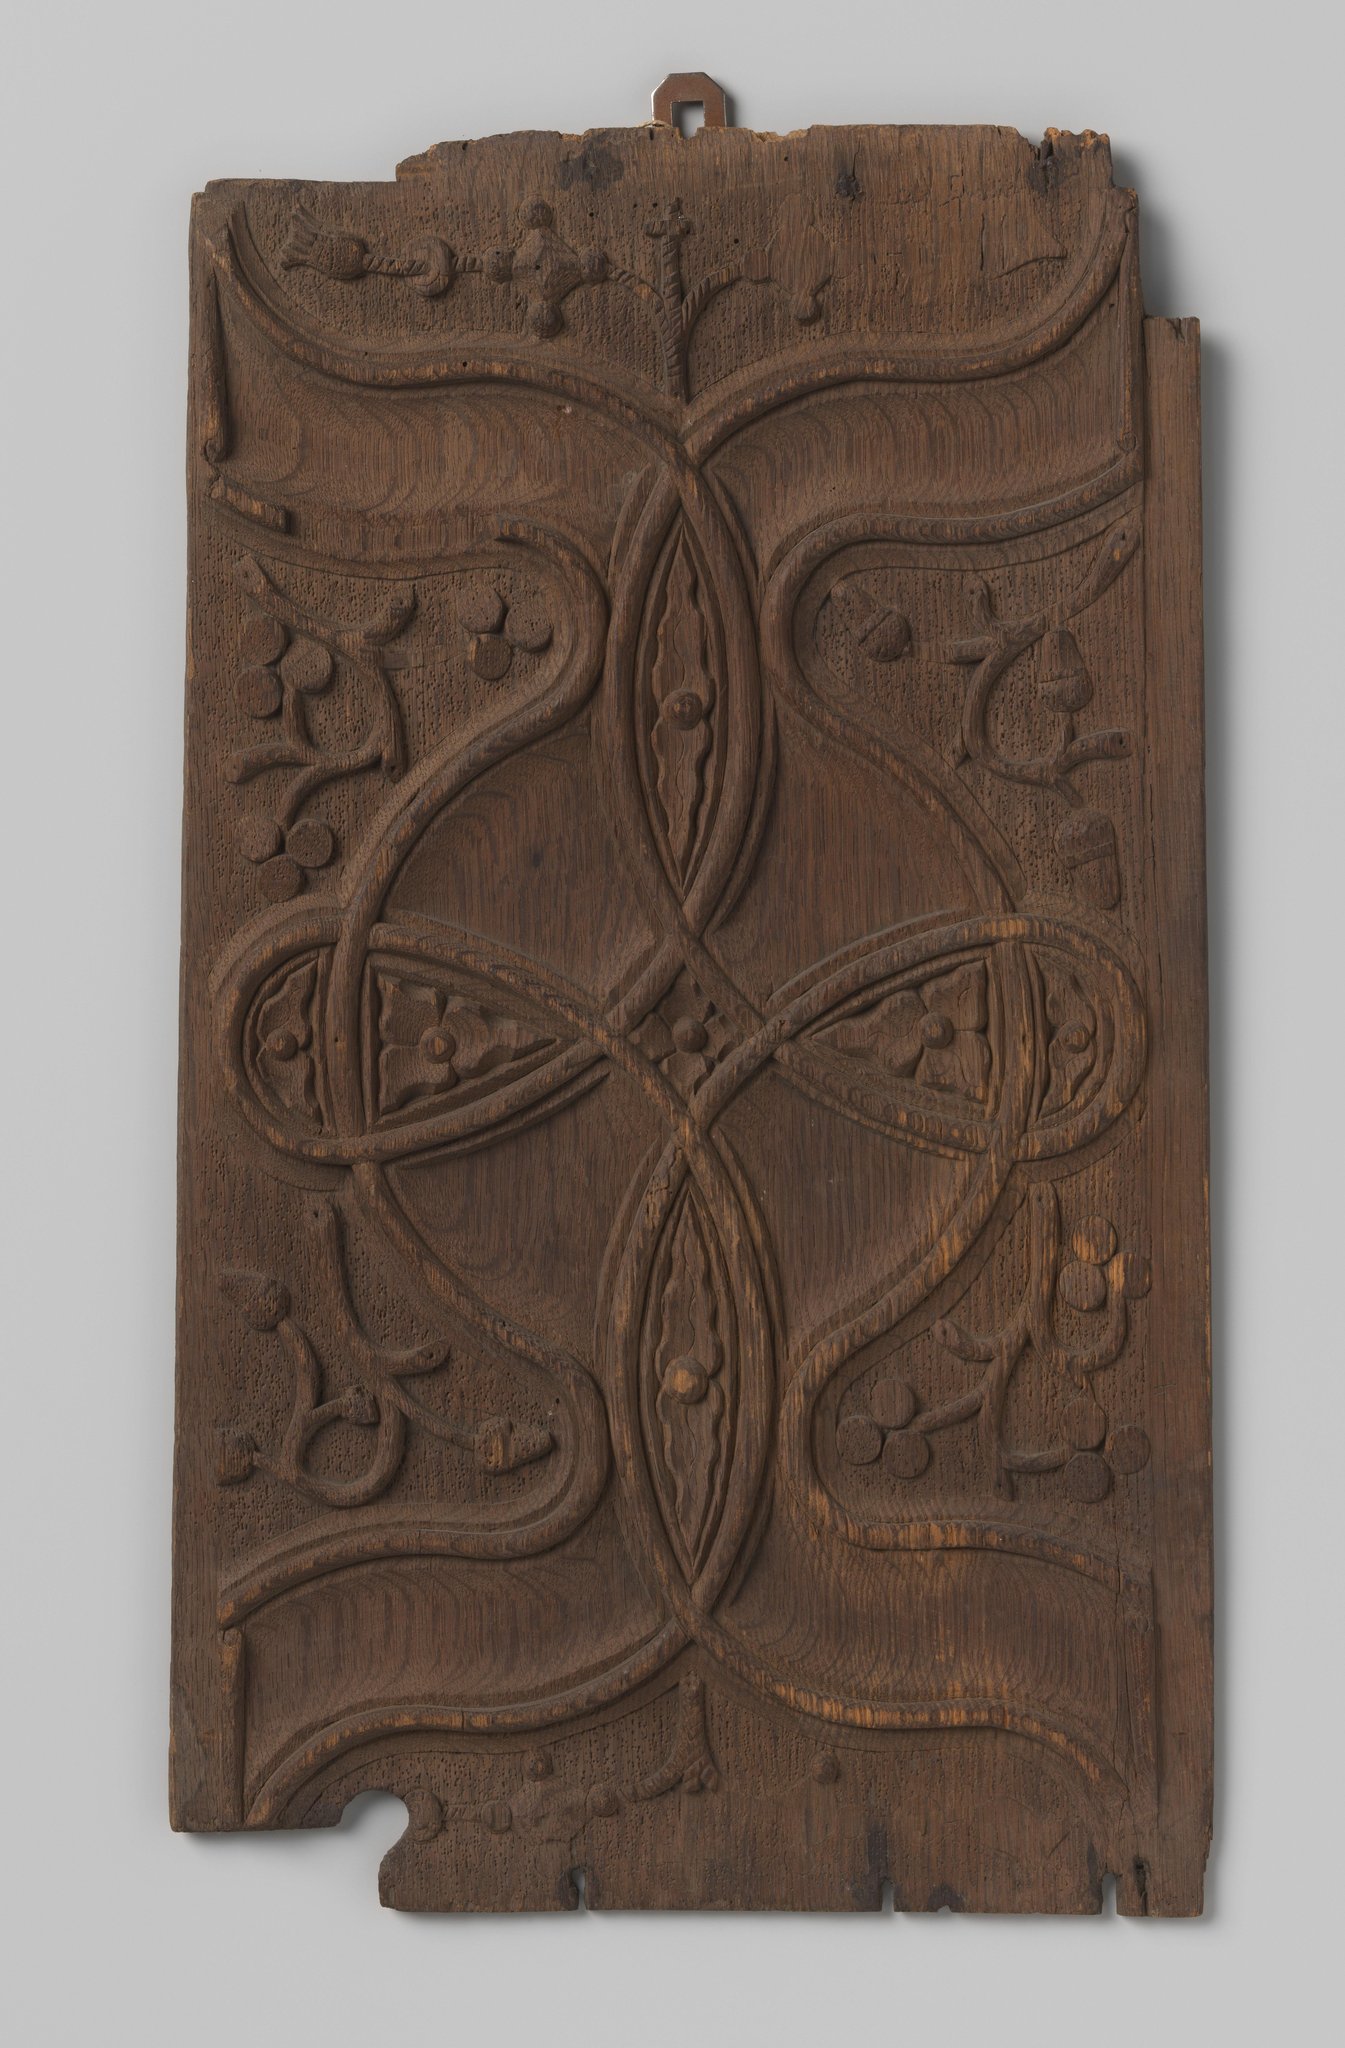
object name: betimmering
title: Interieuronderdeel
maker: Anonymous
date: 1500-1550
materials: wood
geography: netherlands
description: Paneel, versierd met de uit de "brief" ontwikkelde bladslingers, die een kabeling in het midden vertonen en wingerdtakjes met druiventrossen in de uitgrondingen hebben.